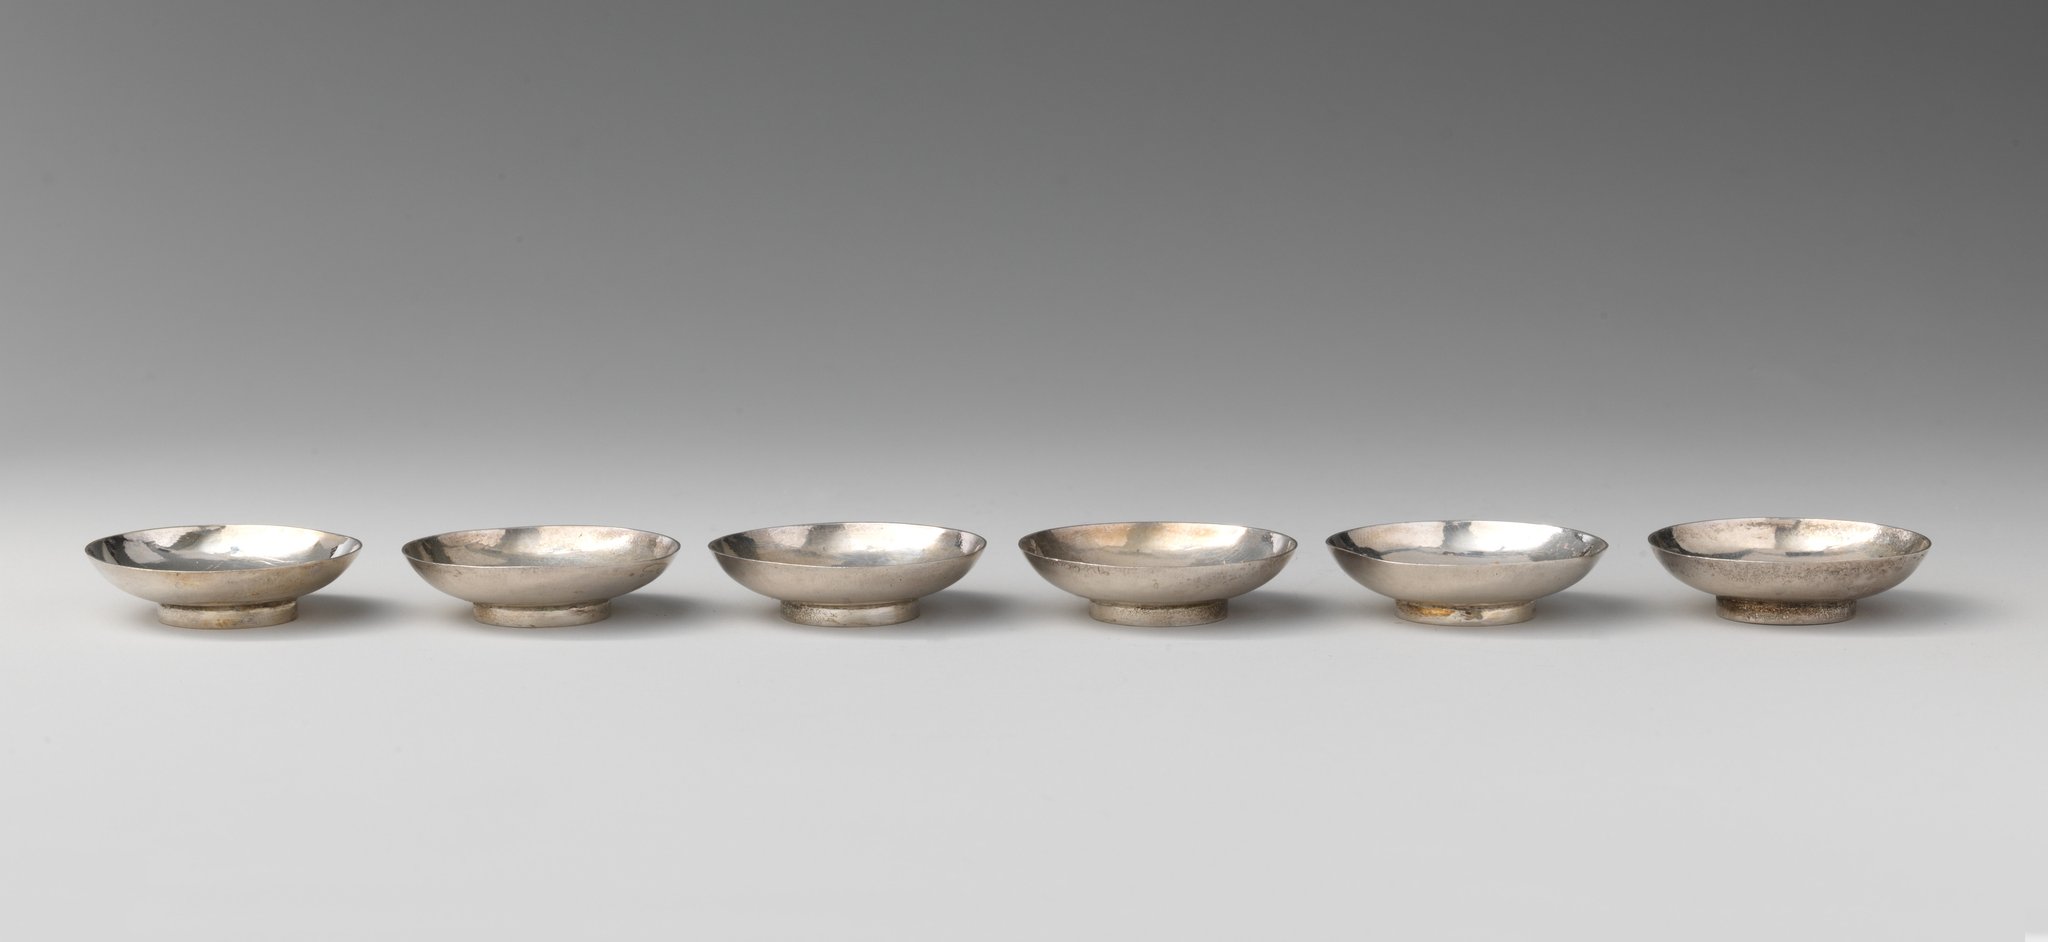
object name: saucer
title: Set of six miniature saucers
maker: david clayton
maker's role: artist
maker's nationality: british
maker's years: 1659-1719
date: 1720-1730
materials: silver